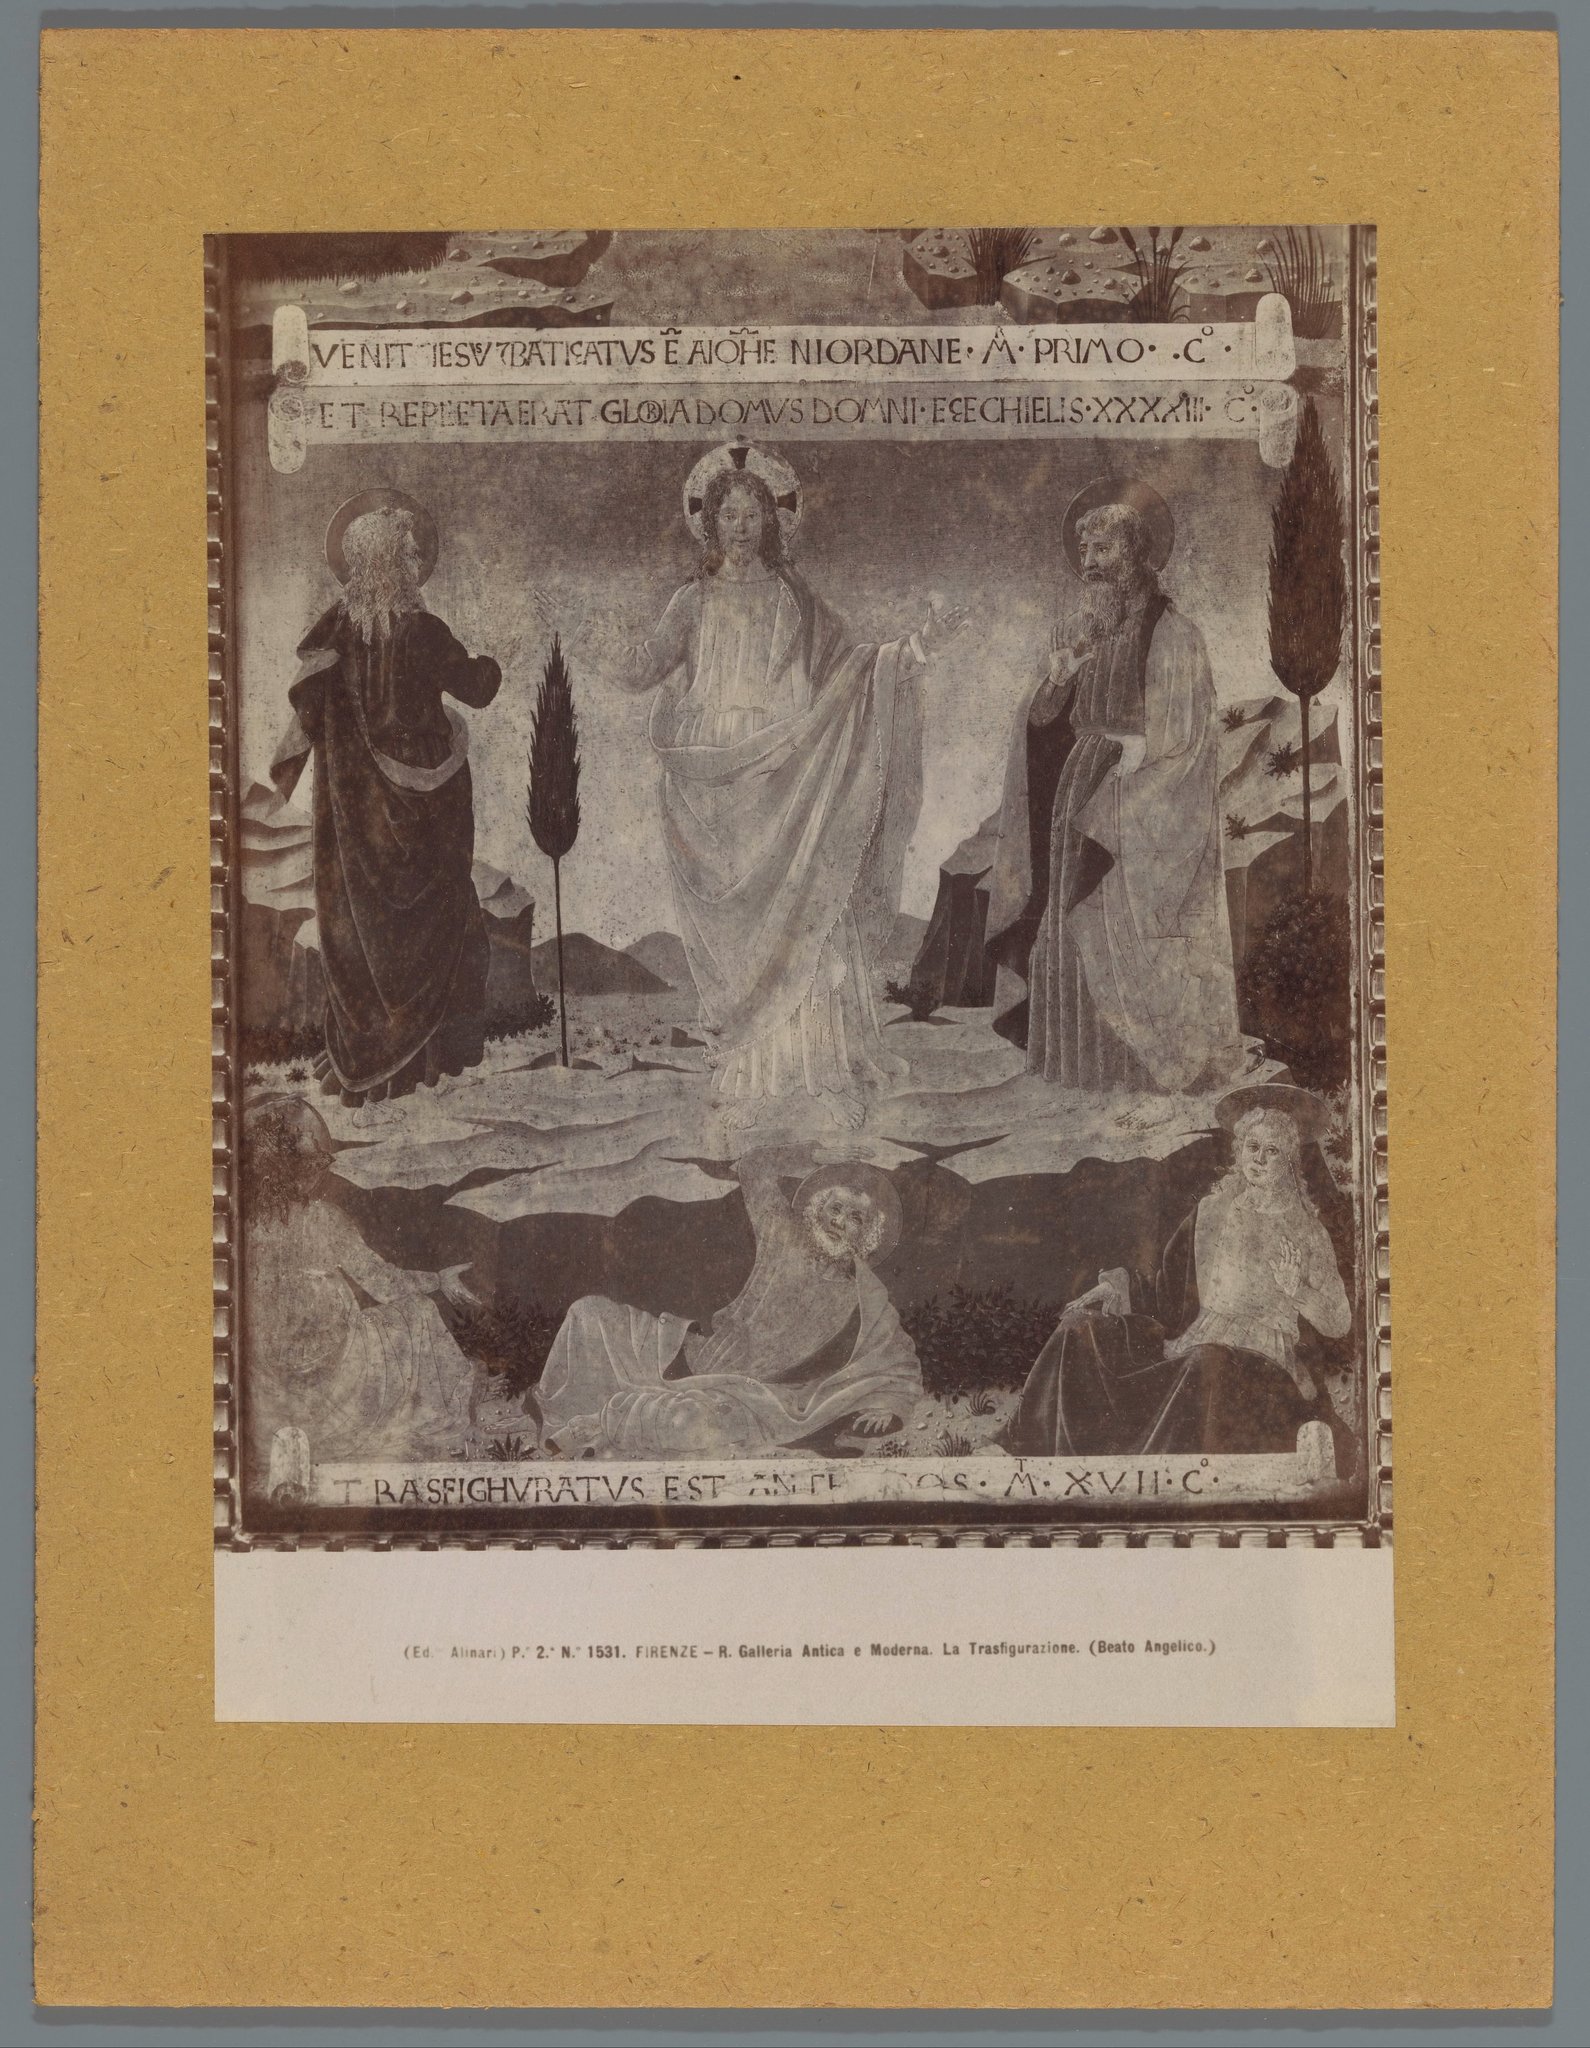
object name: photograph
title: FIRENZE - R. Galleria Antica e Moderna. La Trasfigurazione.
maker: fra angelico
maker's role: painter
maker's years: 1400-1455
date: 1875-1900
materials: cardboard, photographic support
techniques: albumen print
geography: florence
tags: christ, peter, james and john climb the mountain ~ the transfiguration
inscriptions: collector's mark: Lugt 3937, number: ‘P.e 2.a N.o 1531.’